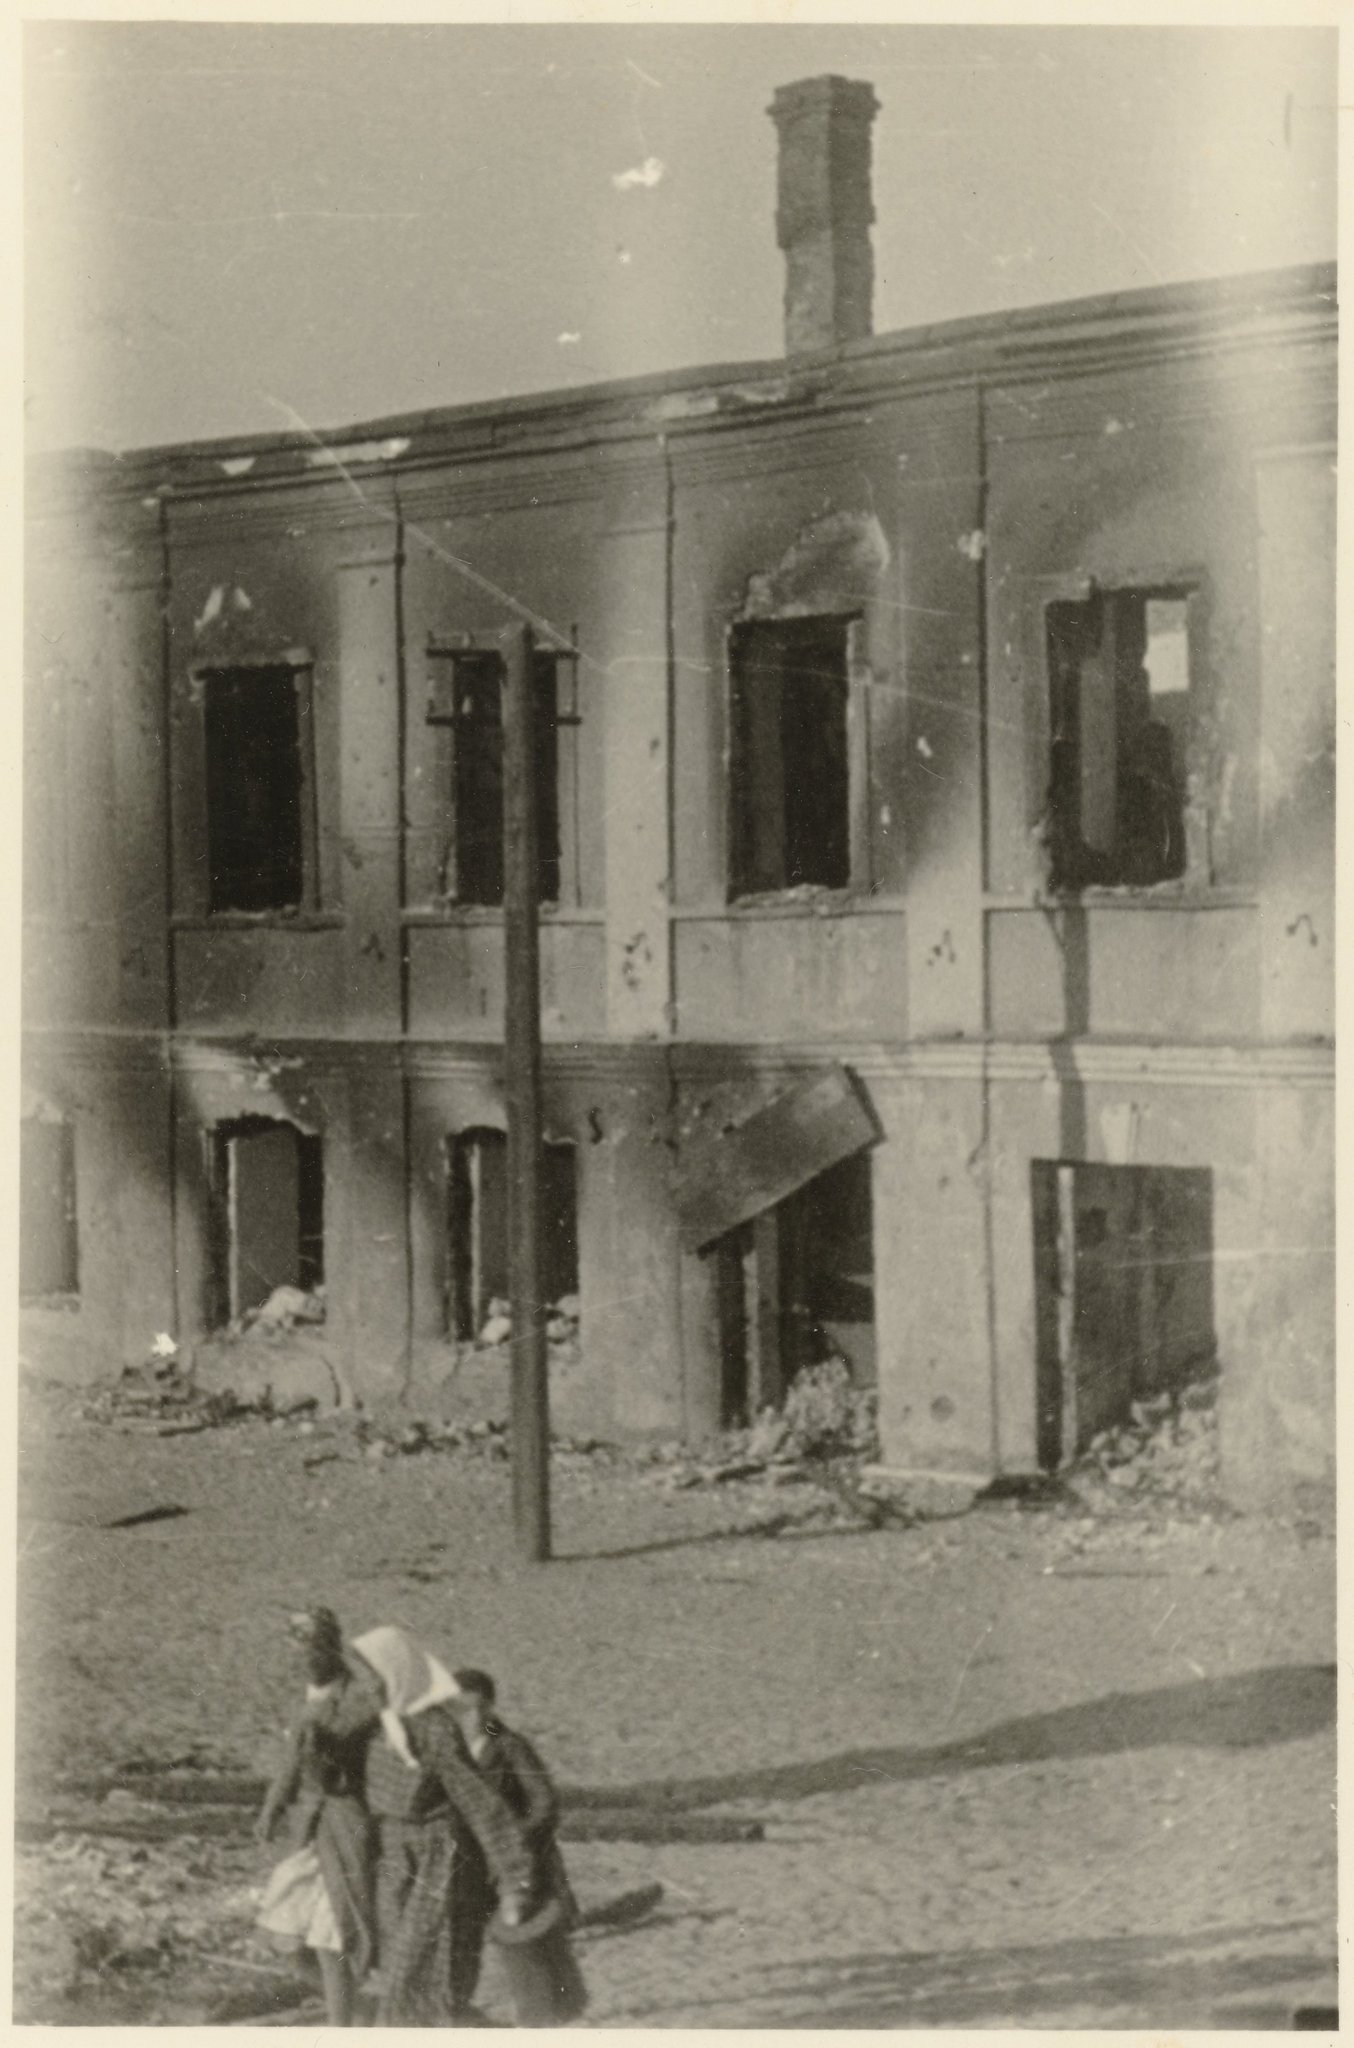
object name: photograph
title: Verbrand gebouw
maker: Anonymous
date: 1940-1945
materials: photographic support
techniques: gelatin silver print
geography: netherlands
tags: germany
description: Twee vrouwen, een met wit hoofddoekje, lopen over straat voor een verbrand gebouw. Foto behorend bij album 'Kriegserinnerungen'.